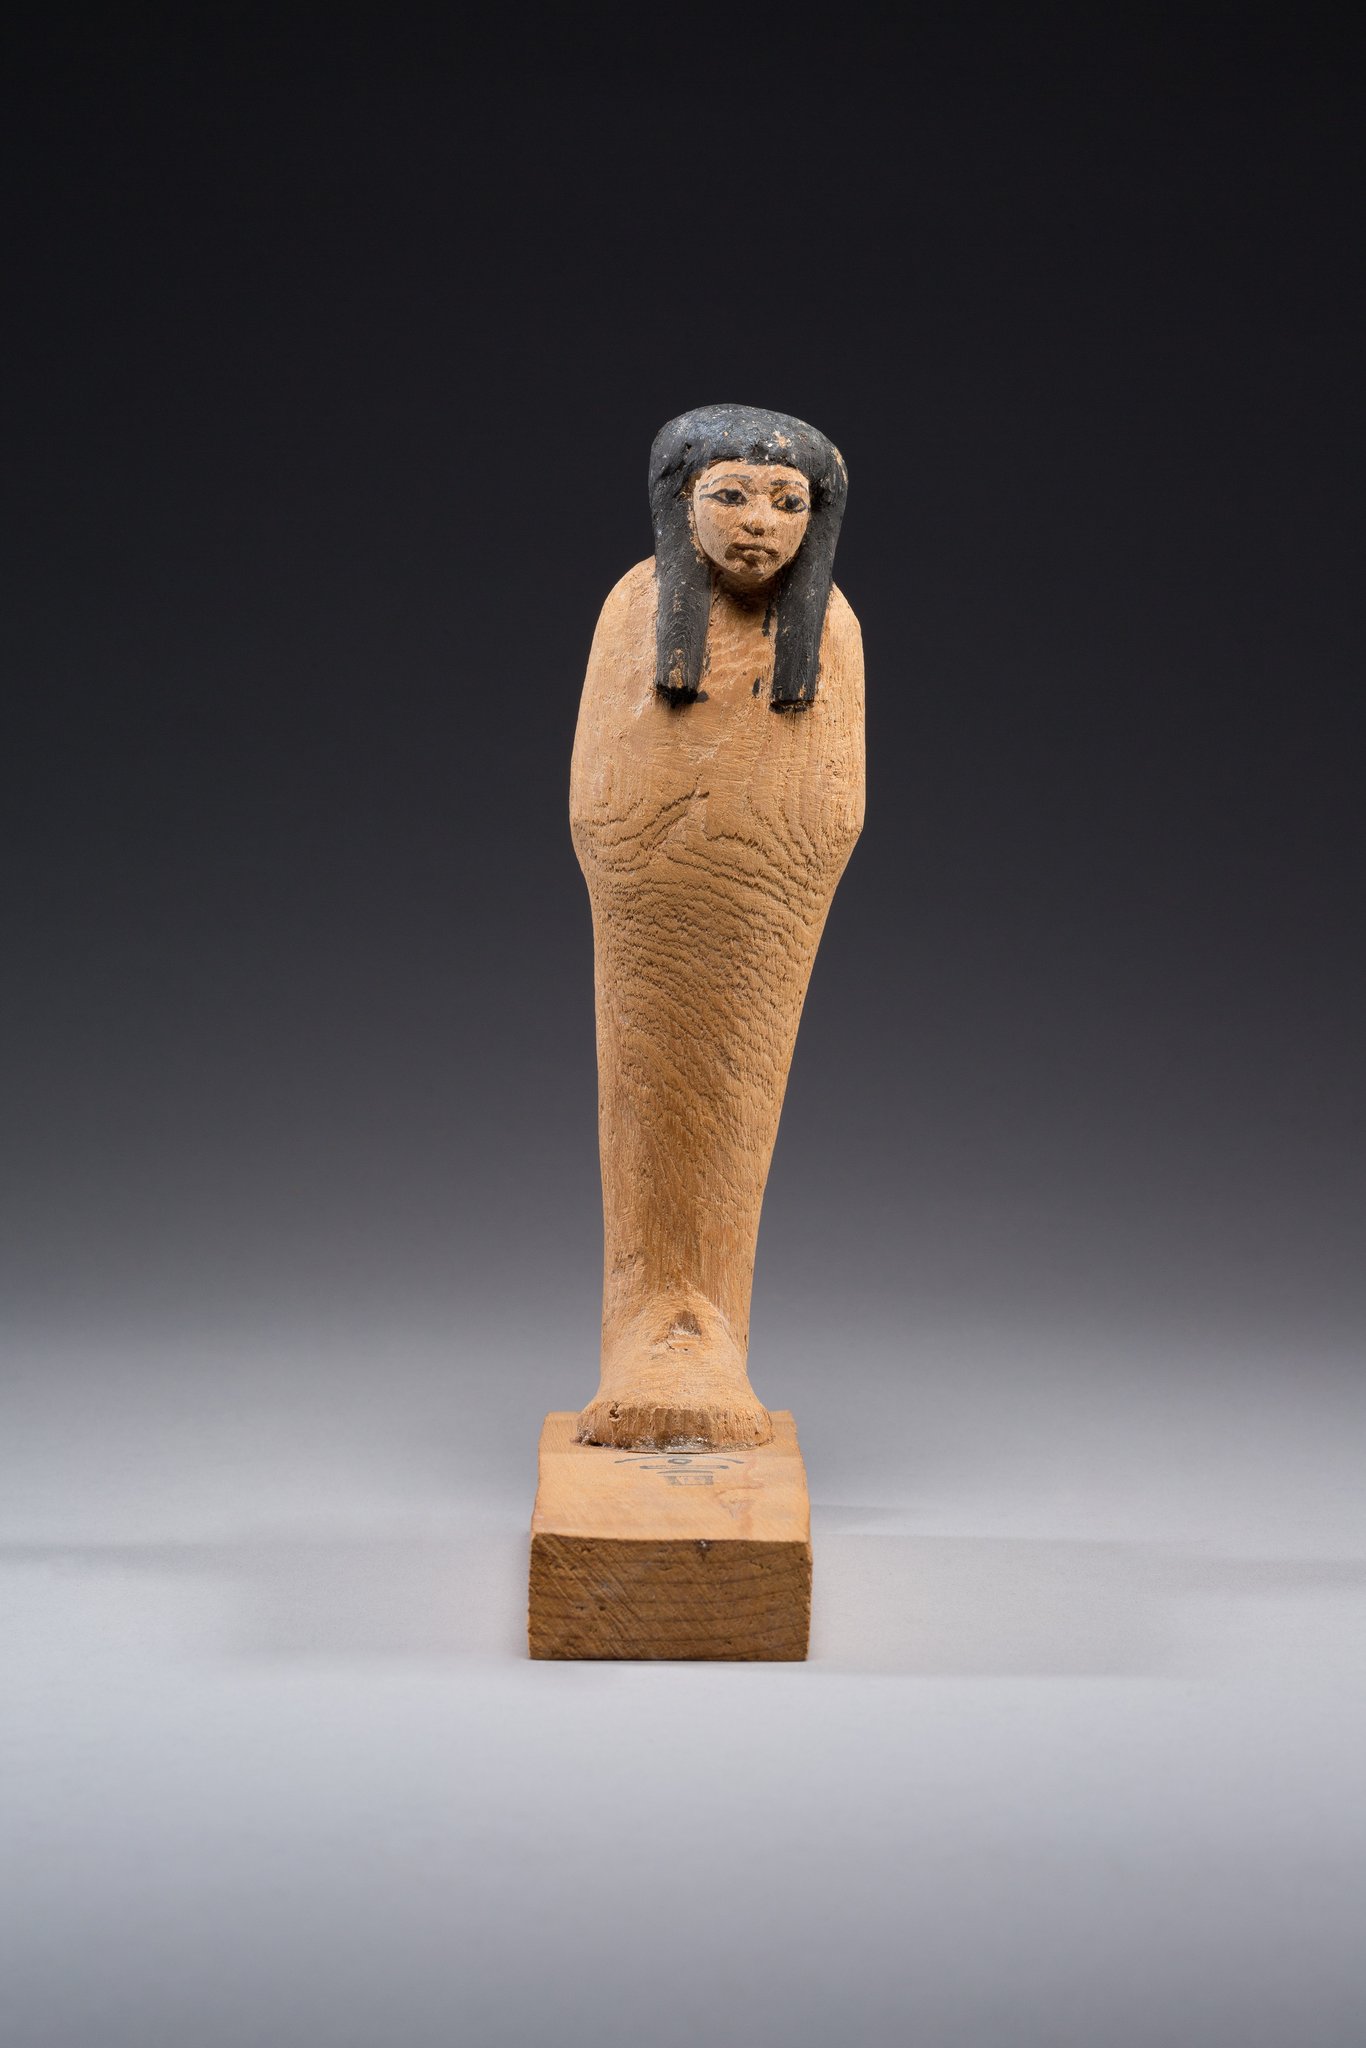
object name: funerary figure, osiride, ahhotep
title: Osirid Figure of Ahhotep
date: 1479-1458 BCE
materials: paint, wood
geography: egypt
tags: queens,portraits